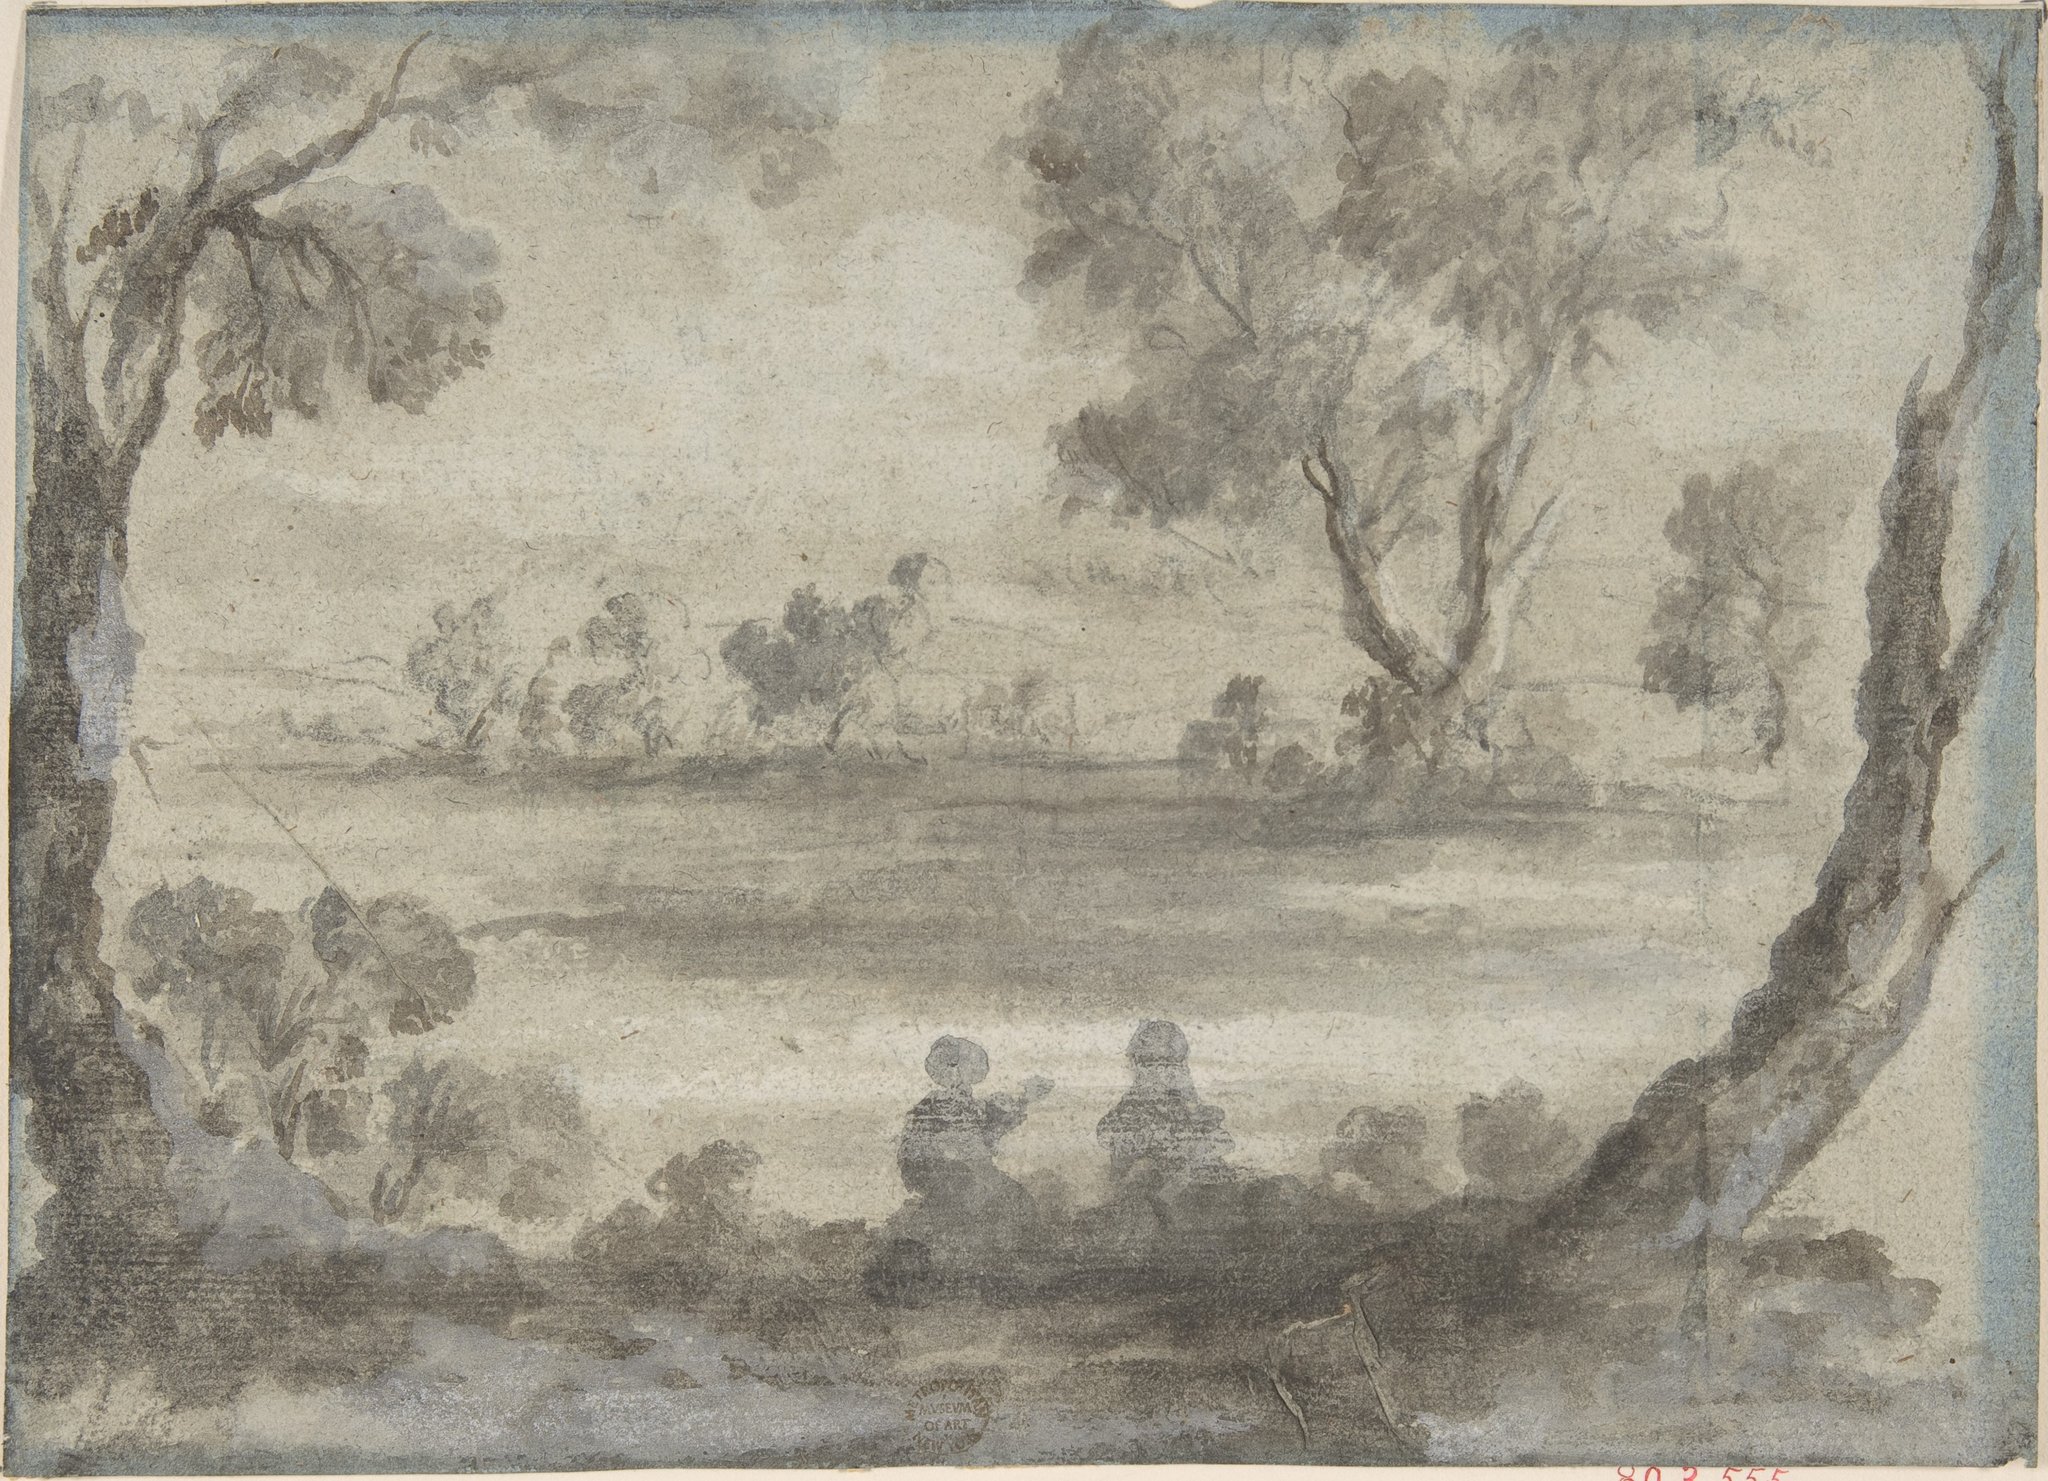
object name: drawing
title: River Scene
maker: anonymous, french, 17th century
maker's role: artist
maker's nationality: french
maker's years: 1600-1700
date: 1601-1700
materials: chalk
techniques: brush, wash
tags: human figures,rivers,trees